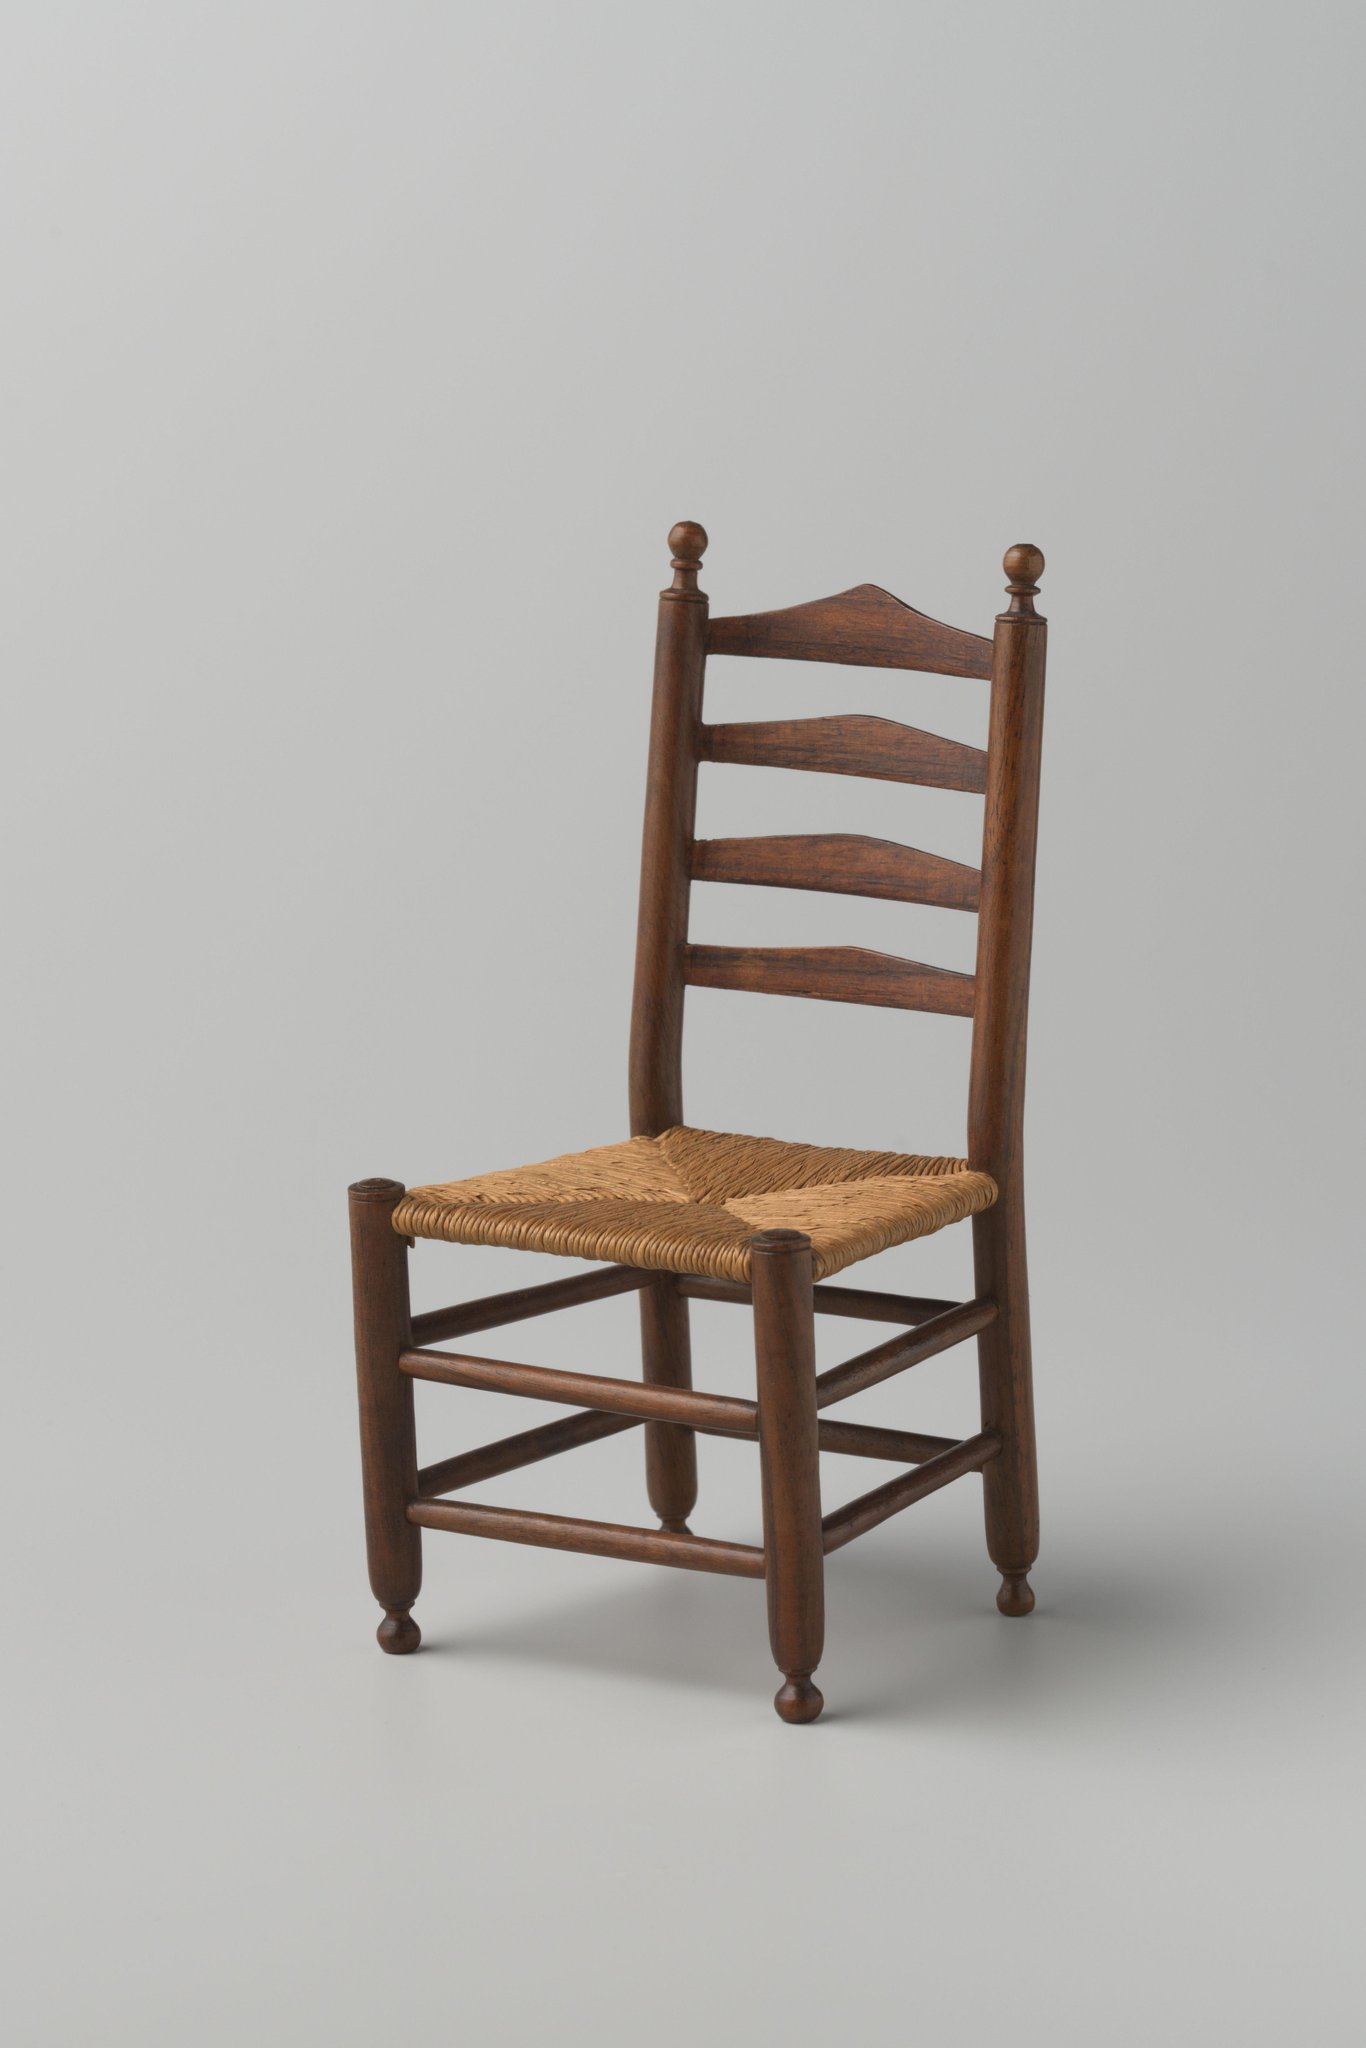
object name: knopstoel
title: Knopstoel met matten zitting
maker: Anonymous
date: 1690-1710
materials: fiber, wood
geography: amsterdam